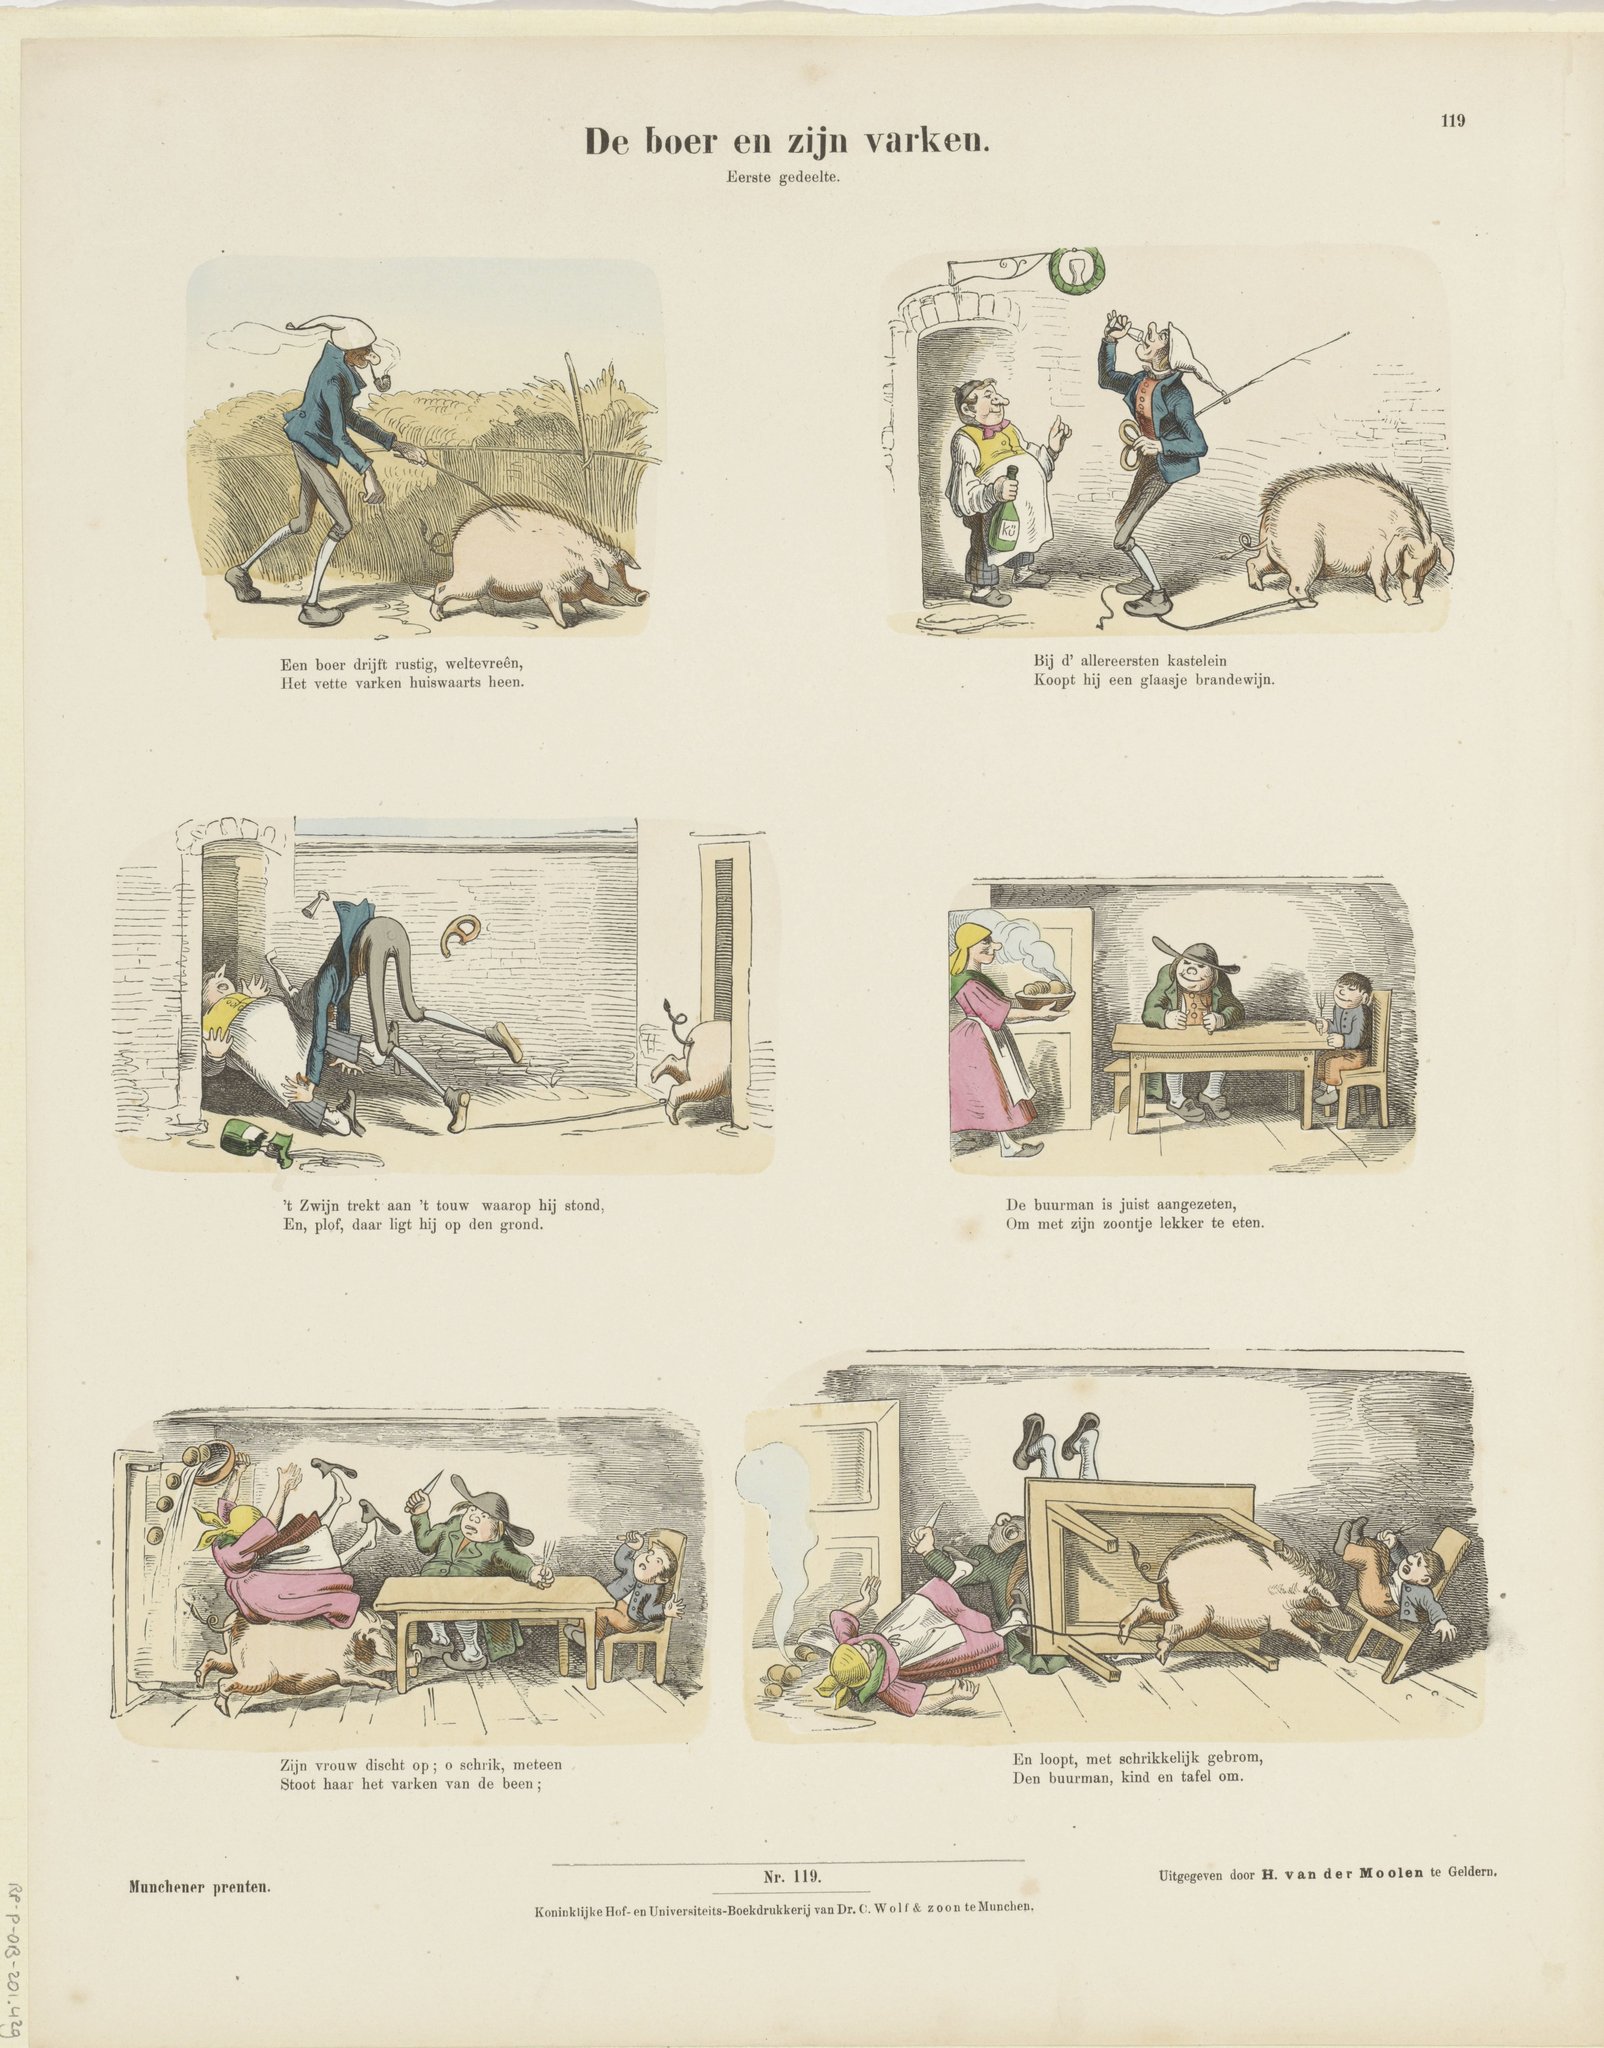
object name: print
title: De boer en zijn varken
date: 1843-1920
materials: paper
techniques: colour, letterpress printing, engraving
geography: munich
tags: pig, farmers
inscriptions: collector's mark: Lugt 2760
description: Blad met 6 voorstellingen van een varken die de boel op zijn kop zet bij een boerenfamilie. Onder elke afbeelding een tweeregelig vers. Genummerd midden onder: Nro. 119. Genummerd rechtsboven: 119.